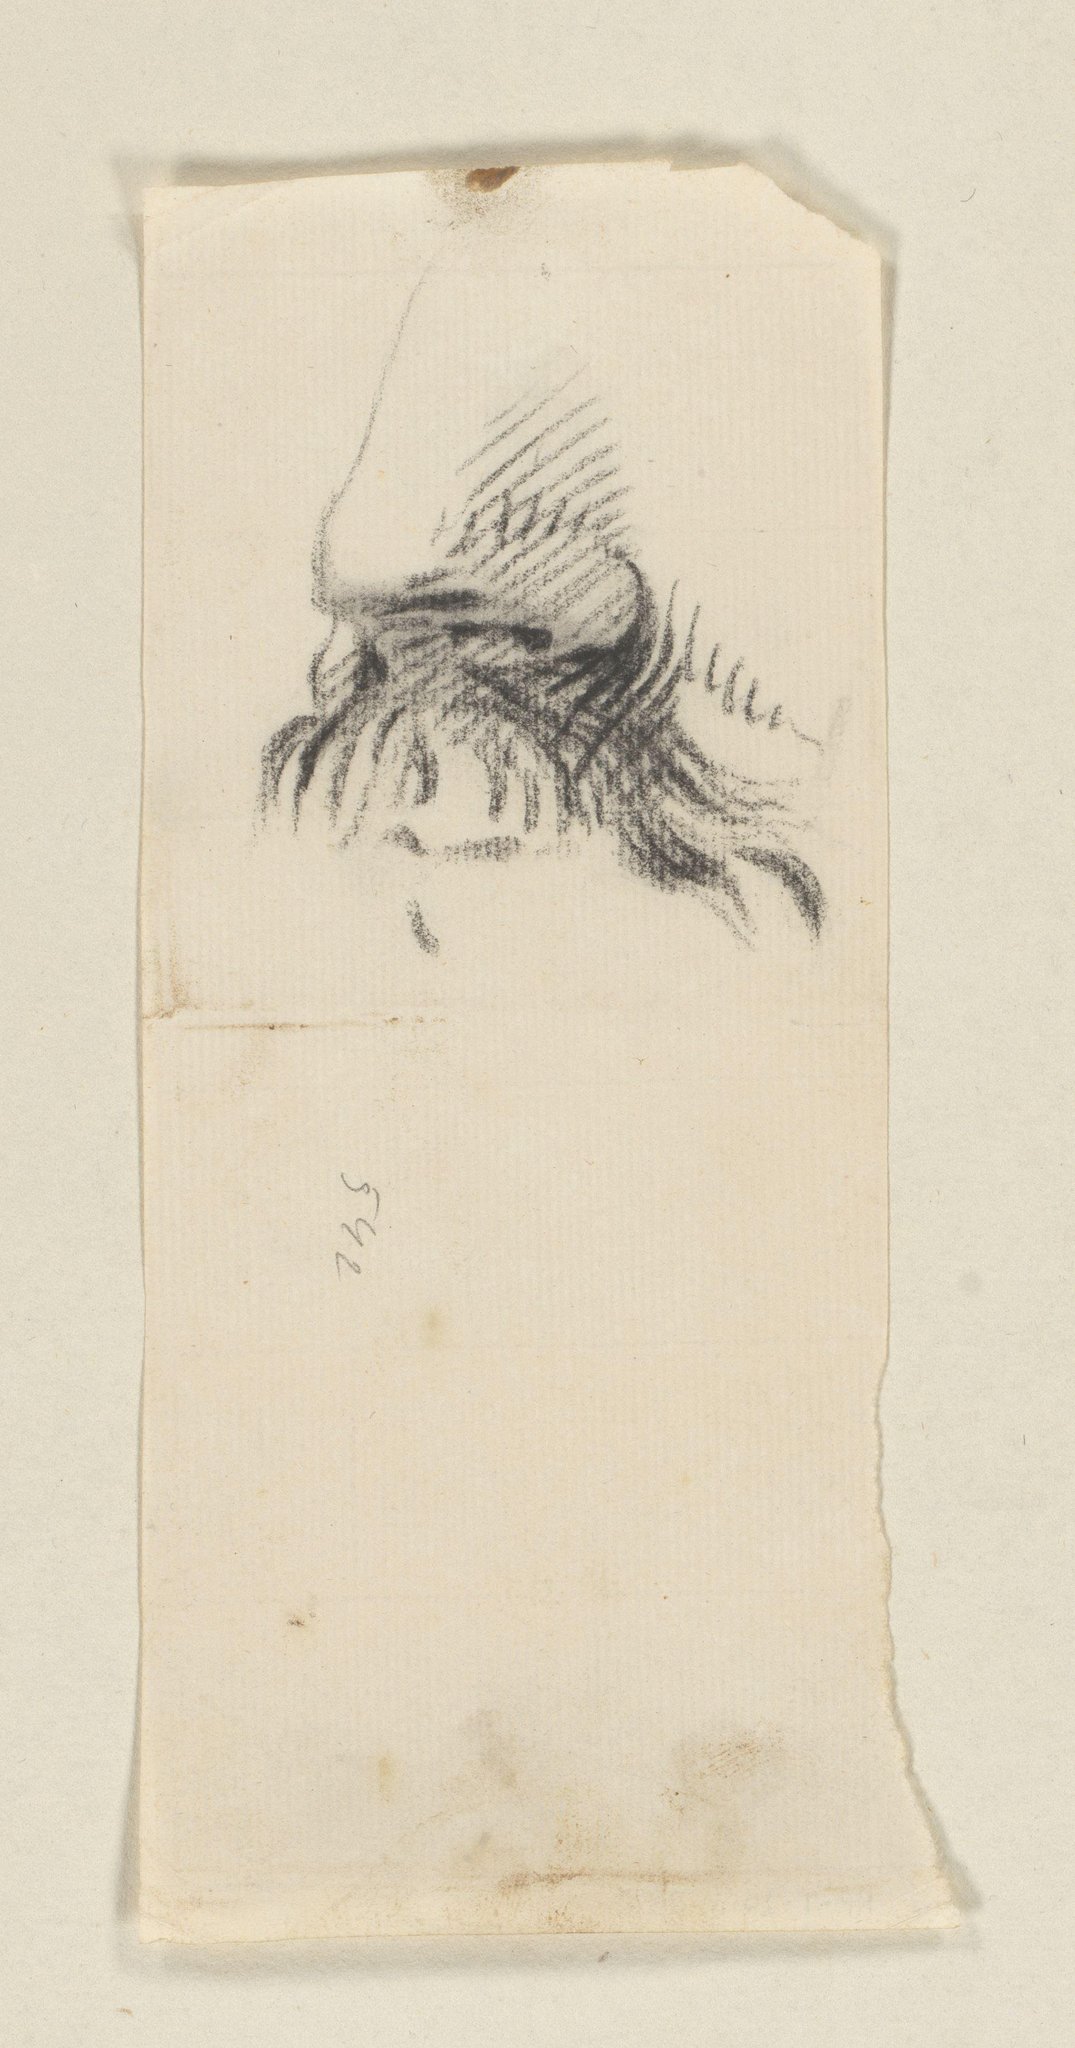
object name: drawing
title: Neus met snor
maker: cornelis ploos van amstel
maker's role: draughtsman, print maker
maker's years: 1726-1798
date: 1736-1798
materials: chalk, paper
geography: amsterdam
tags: moustache, parts of the face: nose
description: De tekening ligt los achterin een album.